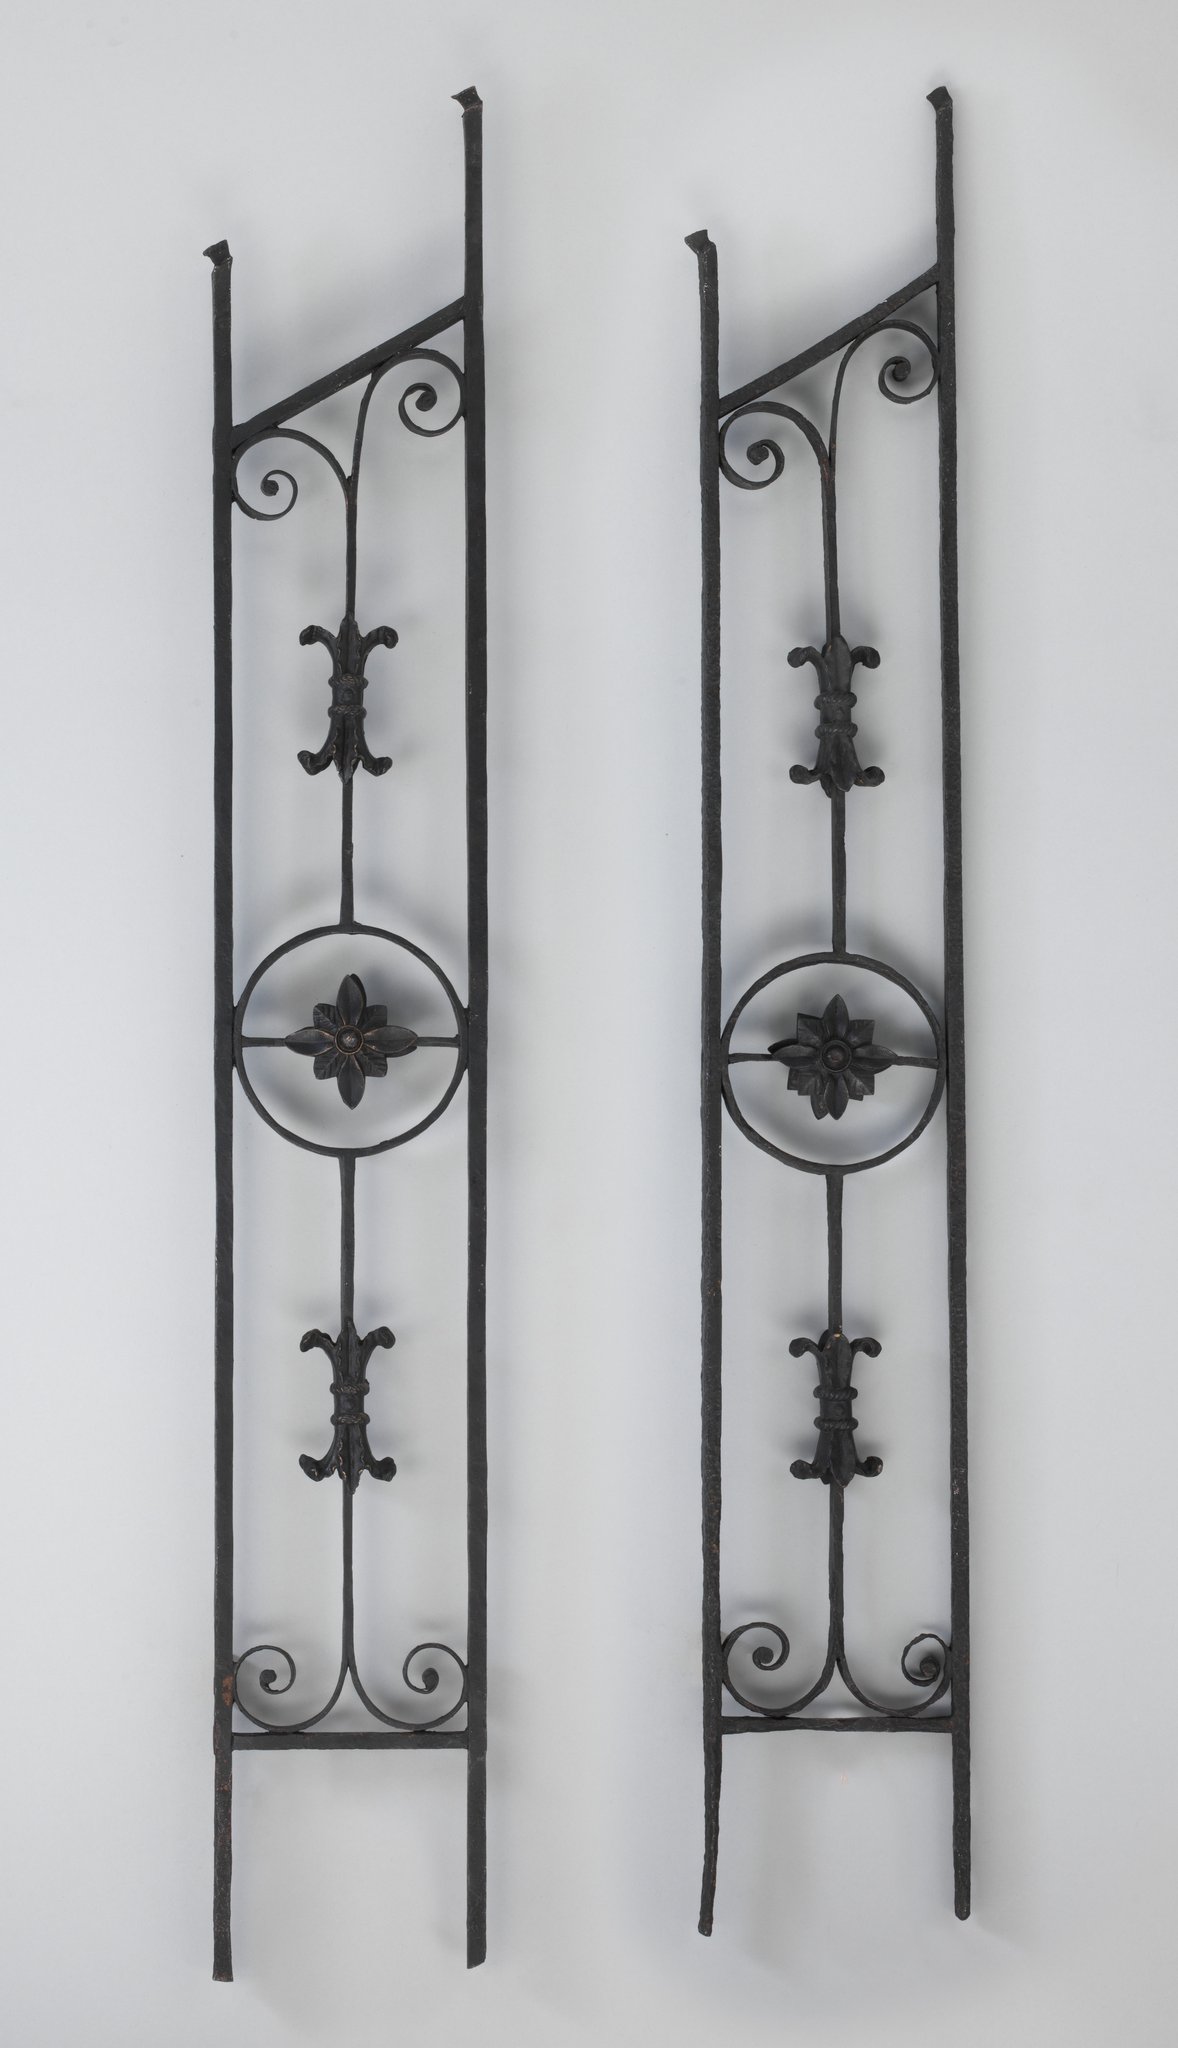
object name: baluster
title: Iron baluster (one of a pair)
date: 1780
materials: brass, iron